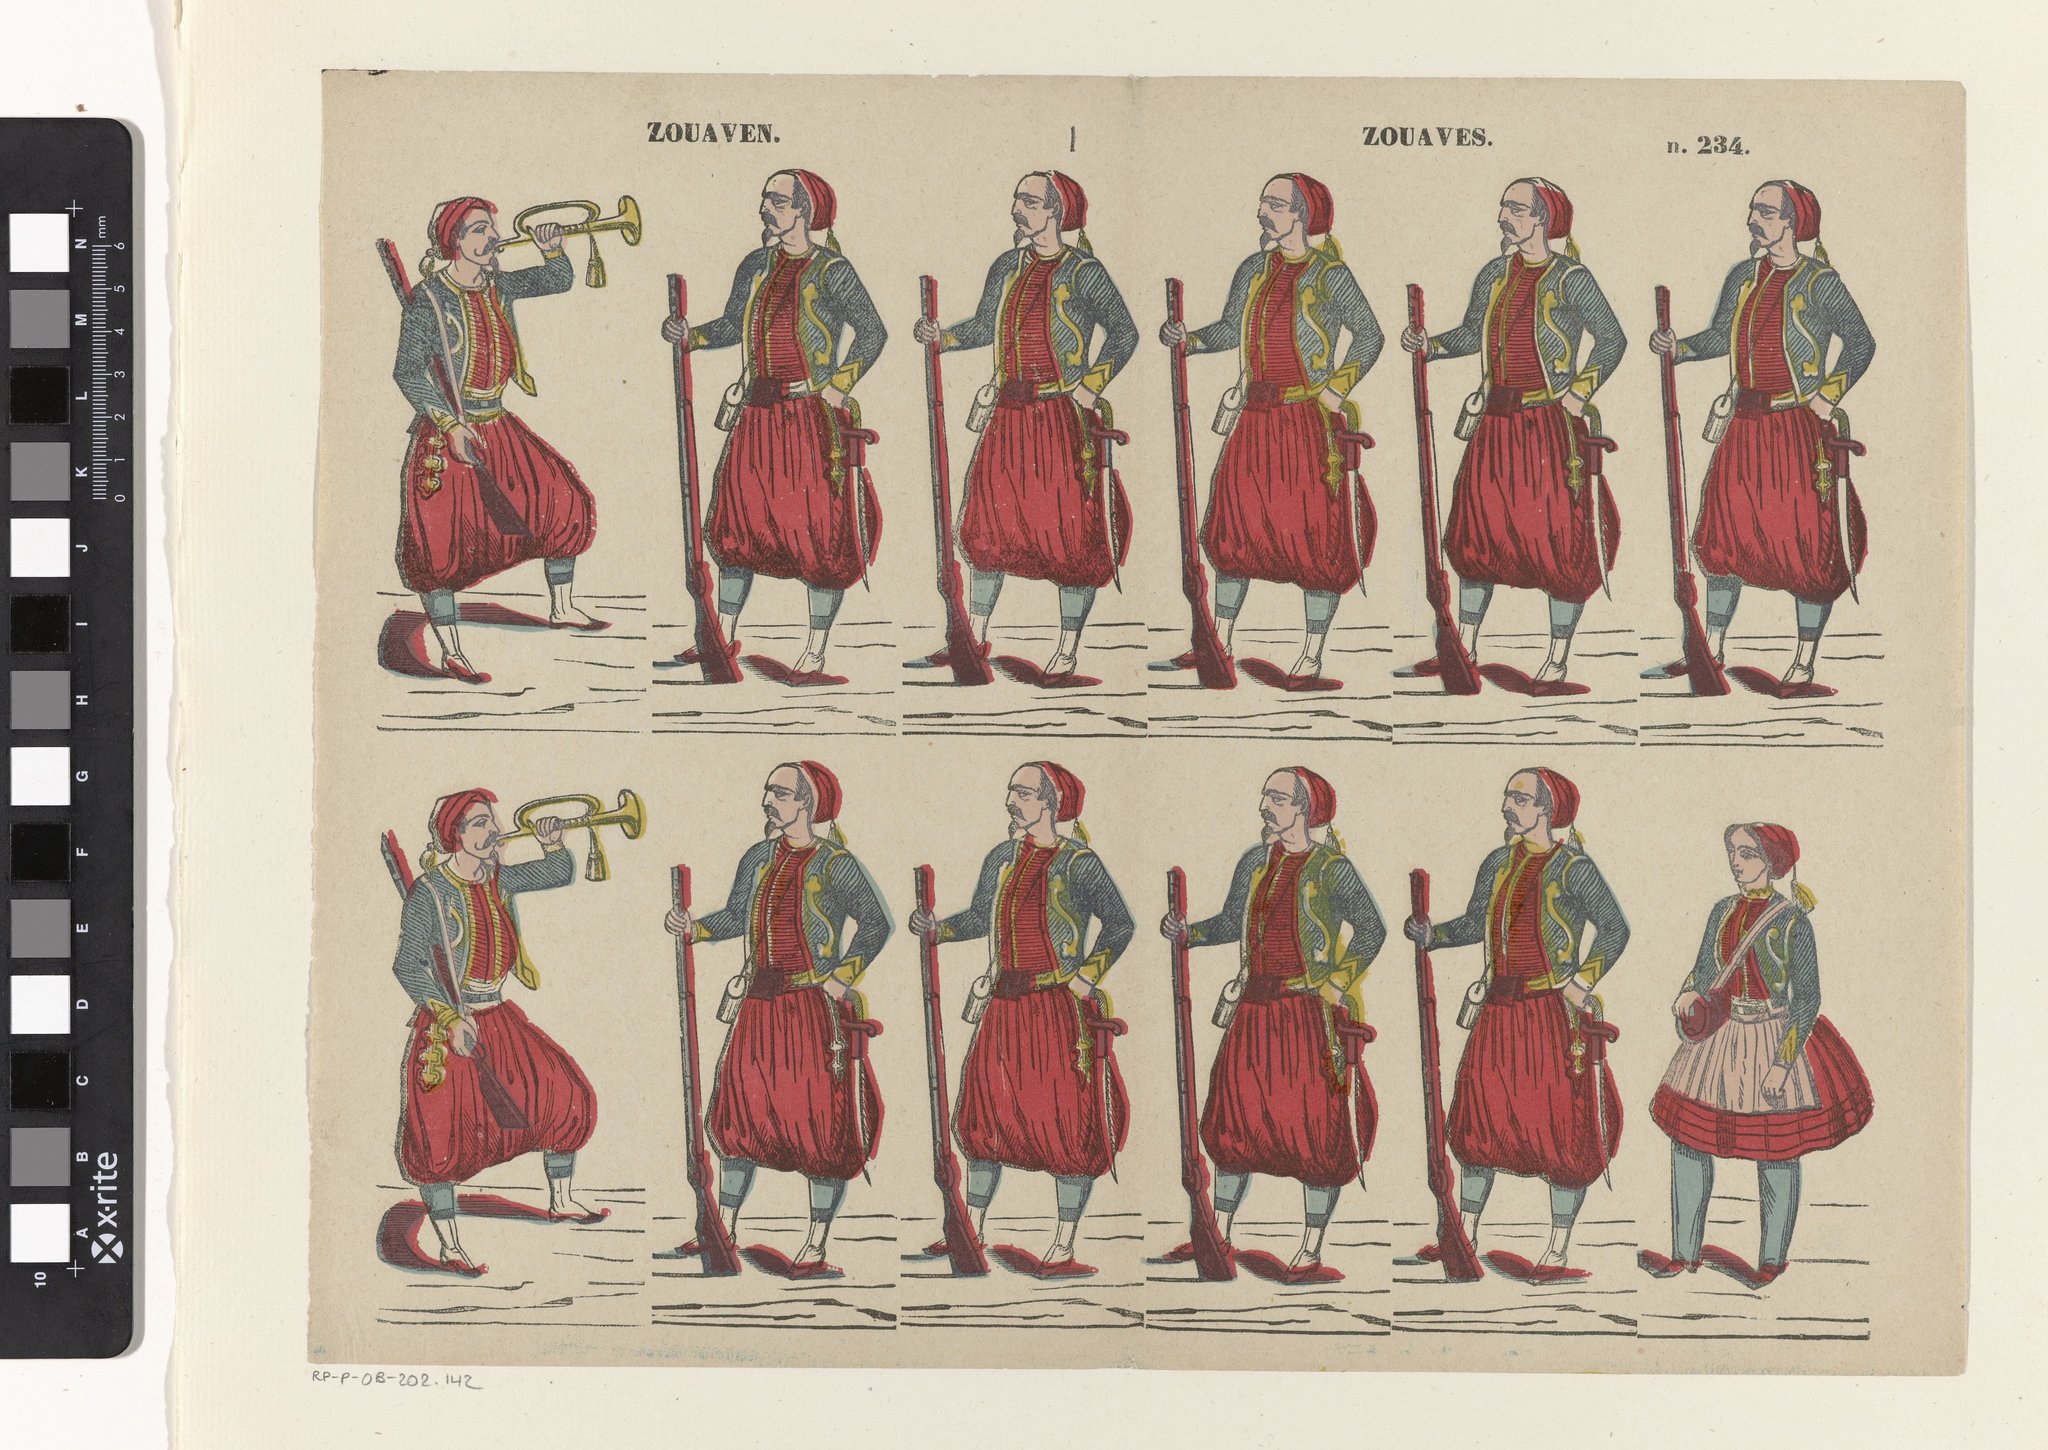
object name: print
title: Zouaven / Zouaves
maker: Anonymous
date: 1833-1911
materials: paper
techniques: lithograph, letterpress printing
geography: turnhout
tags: the soldier; the soldier's life, (military) uniforms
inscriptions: collector's mark: Lugt 2760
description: Blad met 2 horizontale rijen met in totaal 12 voorstellingen van Zoeaven (Franse militairen) met een geweer en een pofbroek. Genummerd rechtsboven: n. 234.